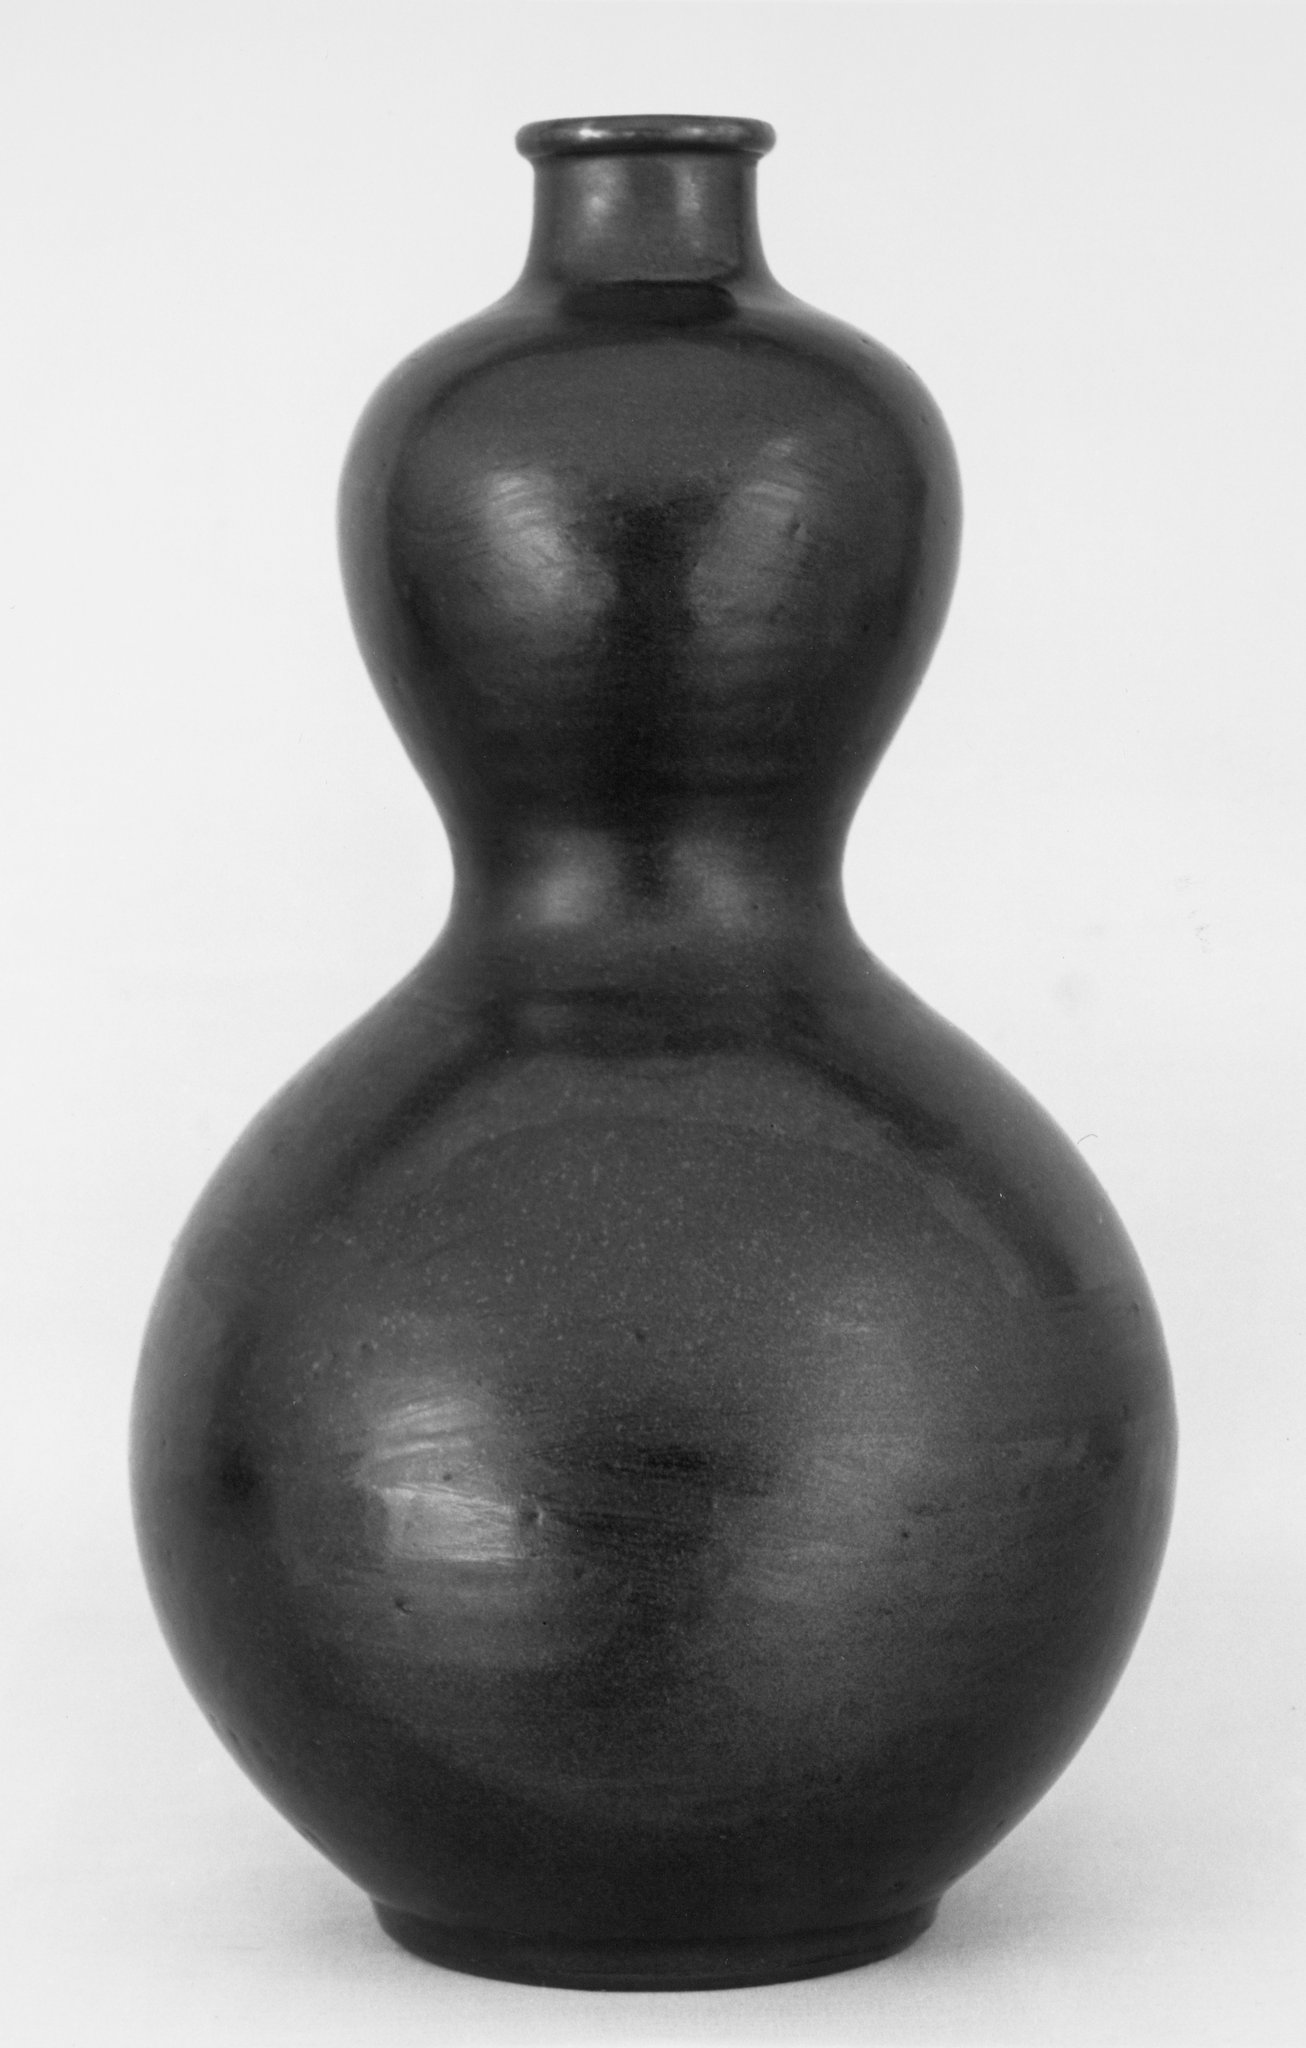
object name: wine bottle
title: Gourd-shaped Bottle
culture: japanese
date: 1801-1900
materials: glaze, pottery